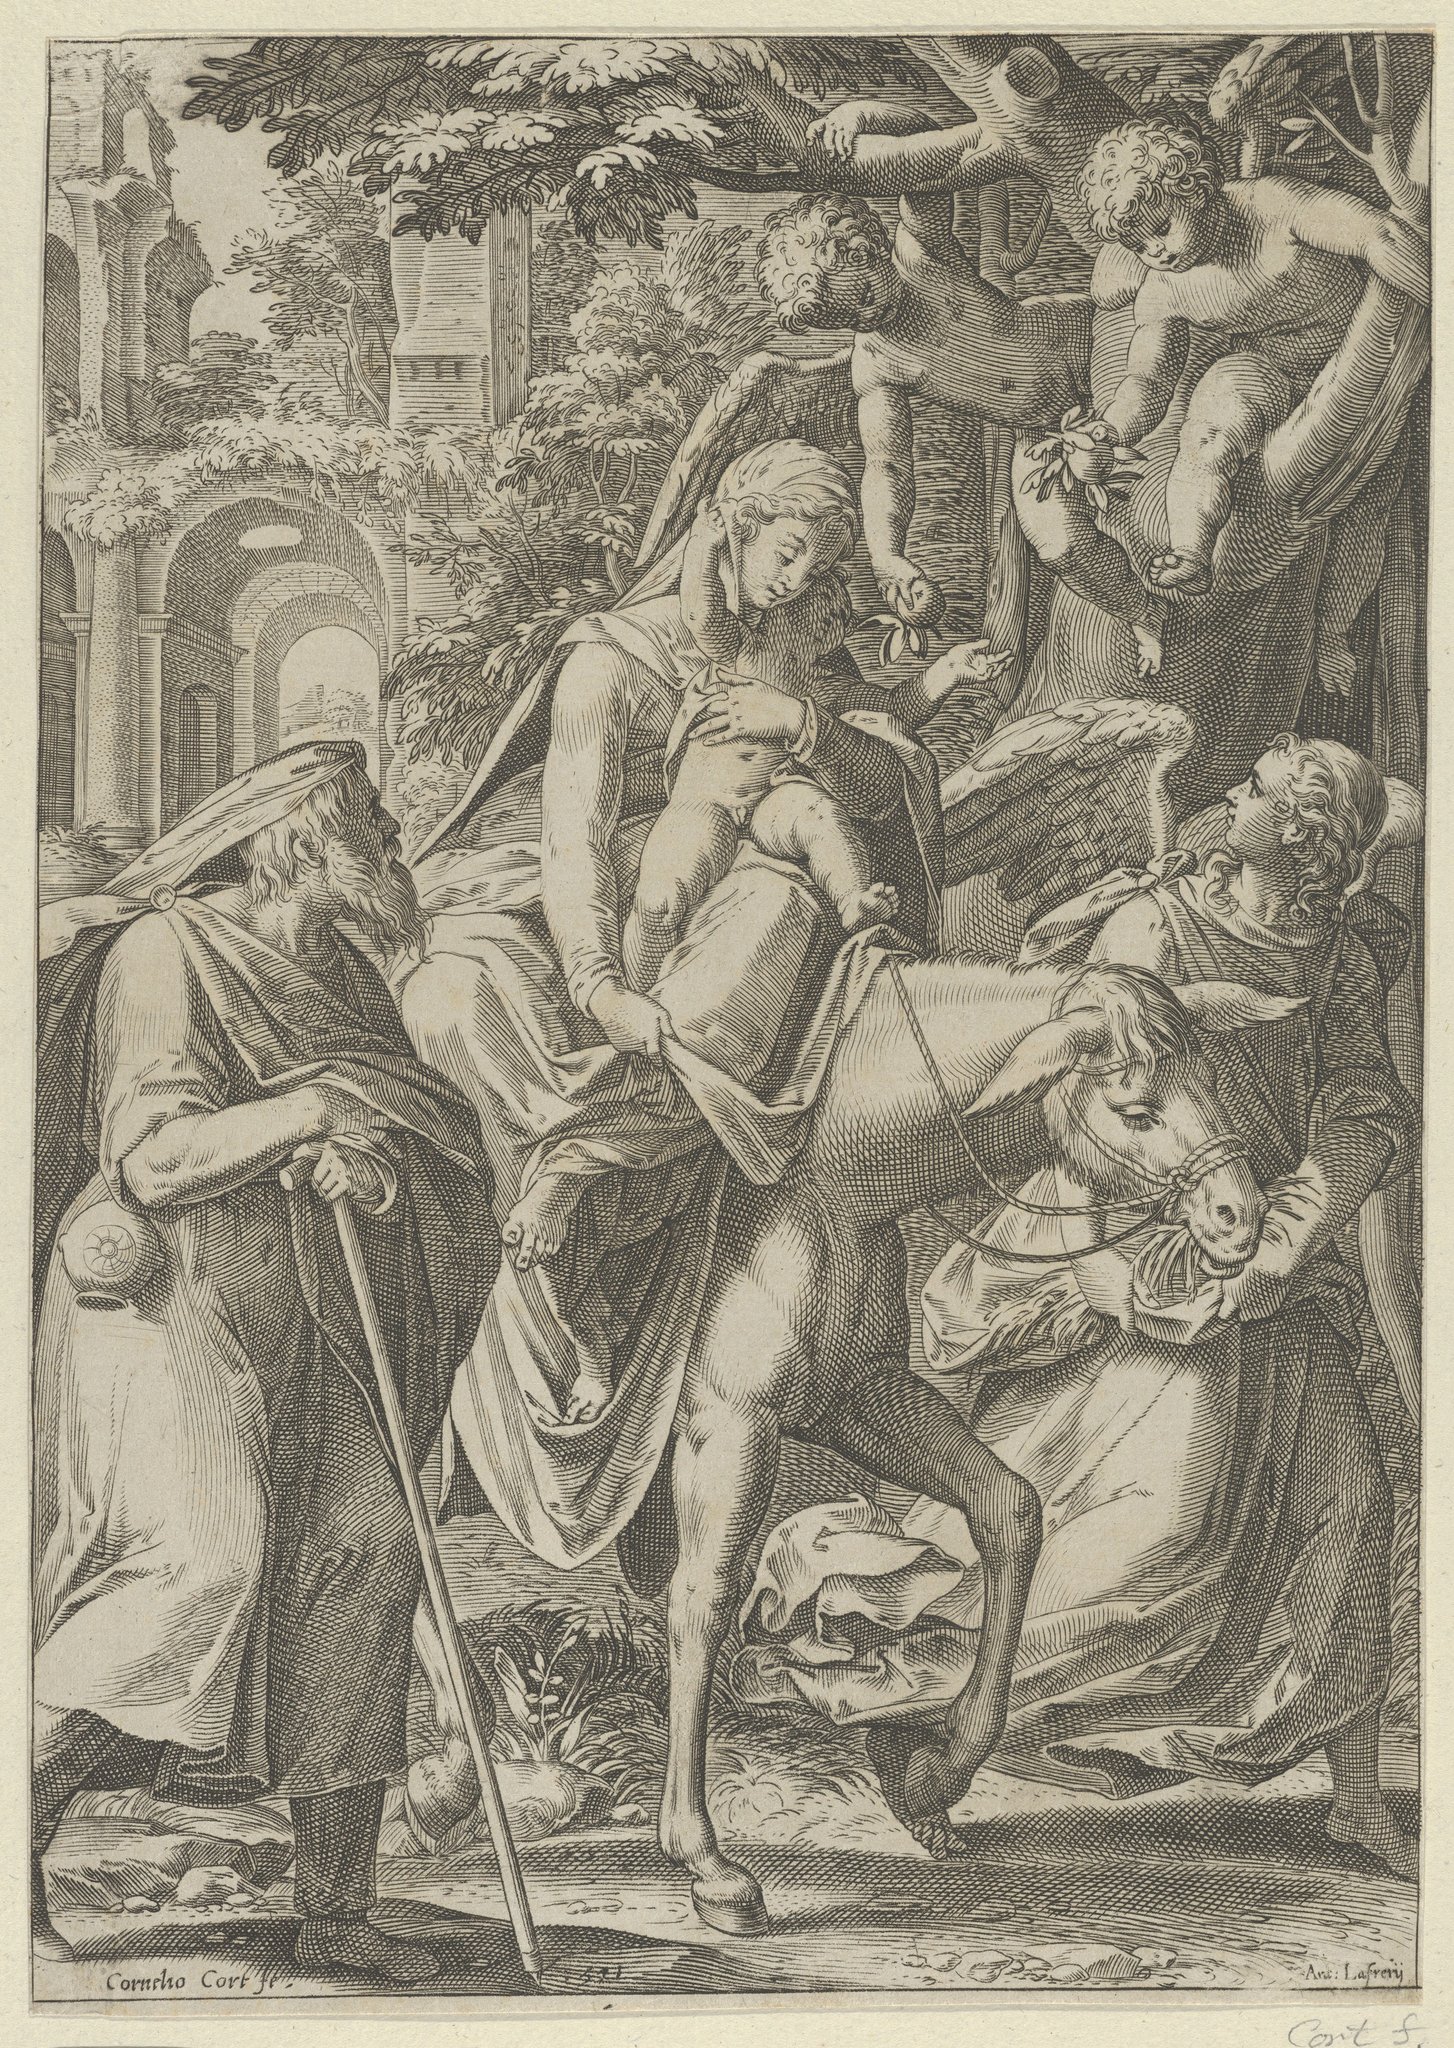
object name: print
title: The Flight into Egypt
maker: cornelis cort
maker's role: artist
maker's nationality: netherlandish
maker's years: 1533-1578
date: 1571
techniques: engraving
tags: animals,men,angels,virgin mary,jesus